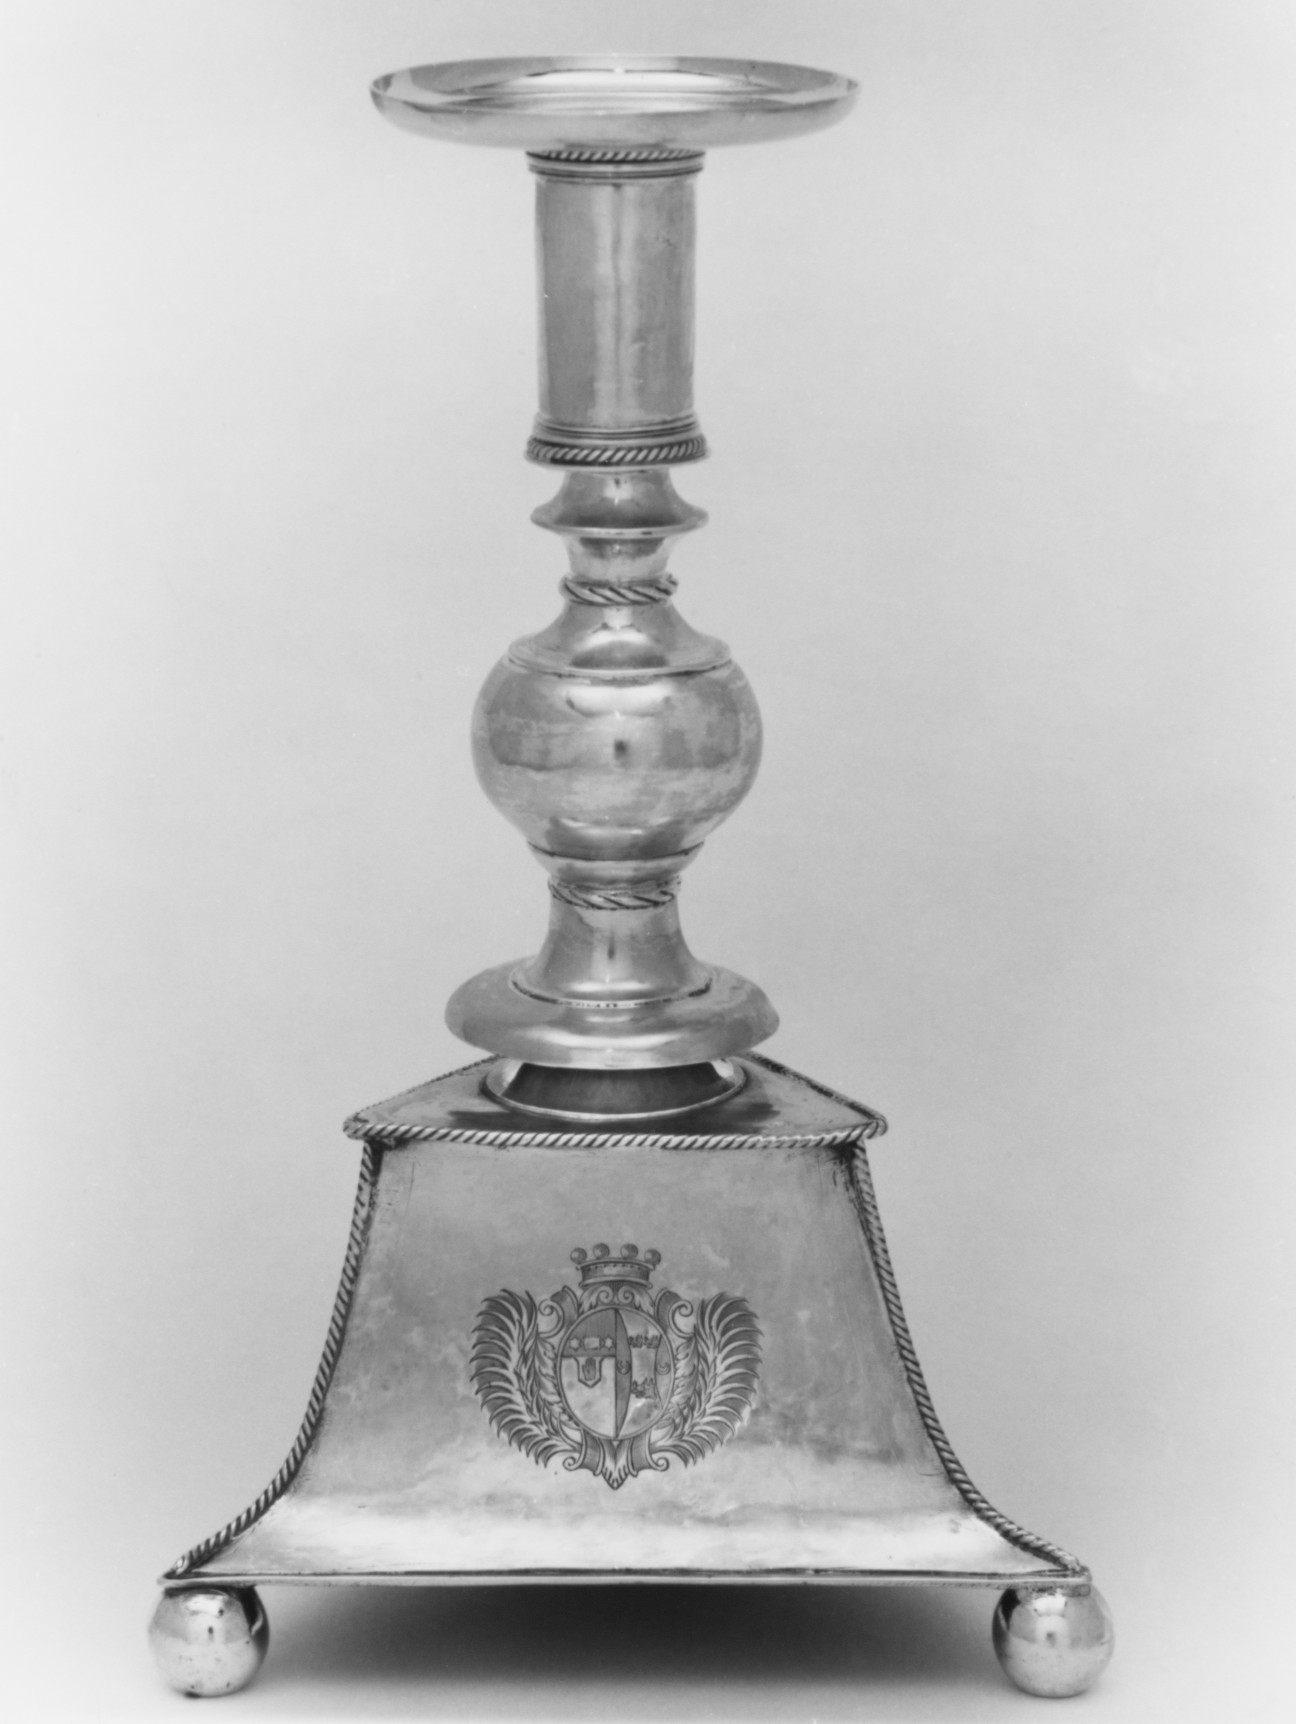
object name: candlestick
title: Candlestick (one of a set of six)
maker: i. o. (probably), york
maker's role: maker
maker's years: 1681-1682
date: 1681-1682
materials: silver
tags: coat of arms